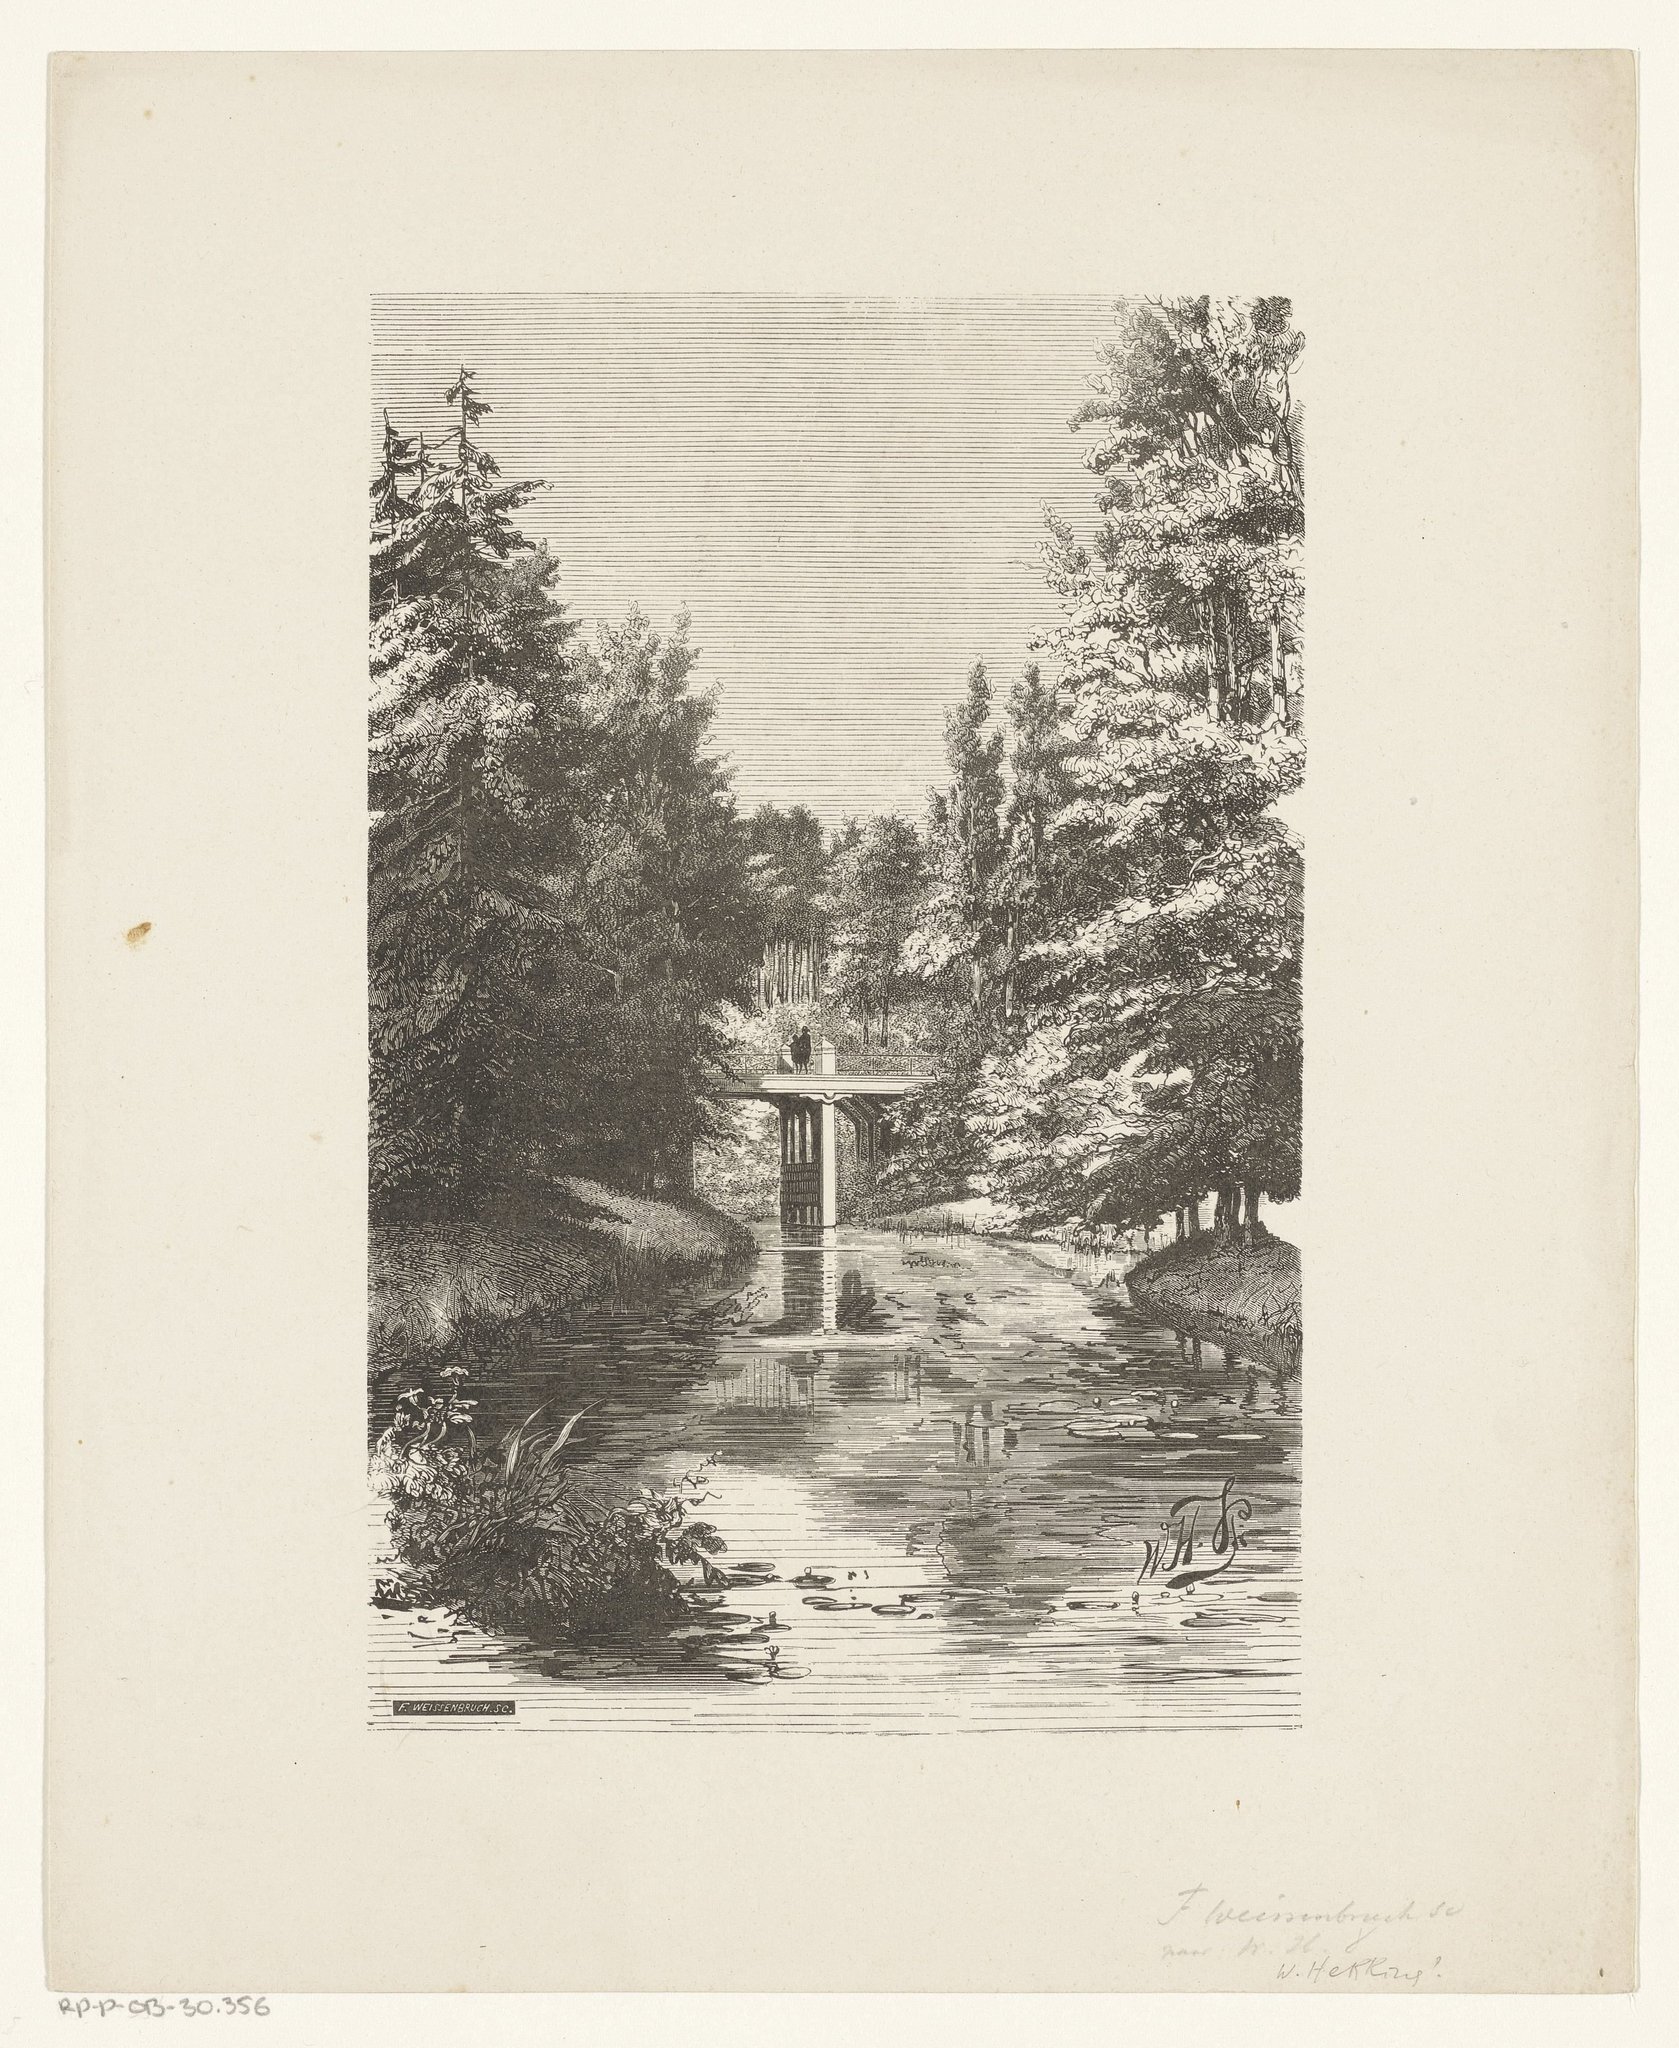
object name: print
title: Rivierlandschap met een brug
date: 1838-1887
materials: paper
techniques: engraving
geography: the hague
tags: landscape with bridge, viaduct or aqueduct (+ city(-scape) with figures, staffage)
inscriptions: collector's mark: Lugt 2228